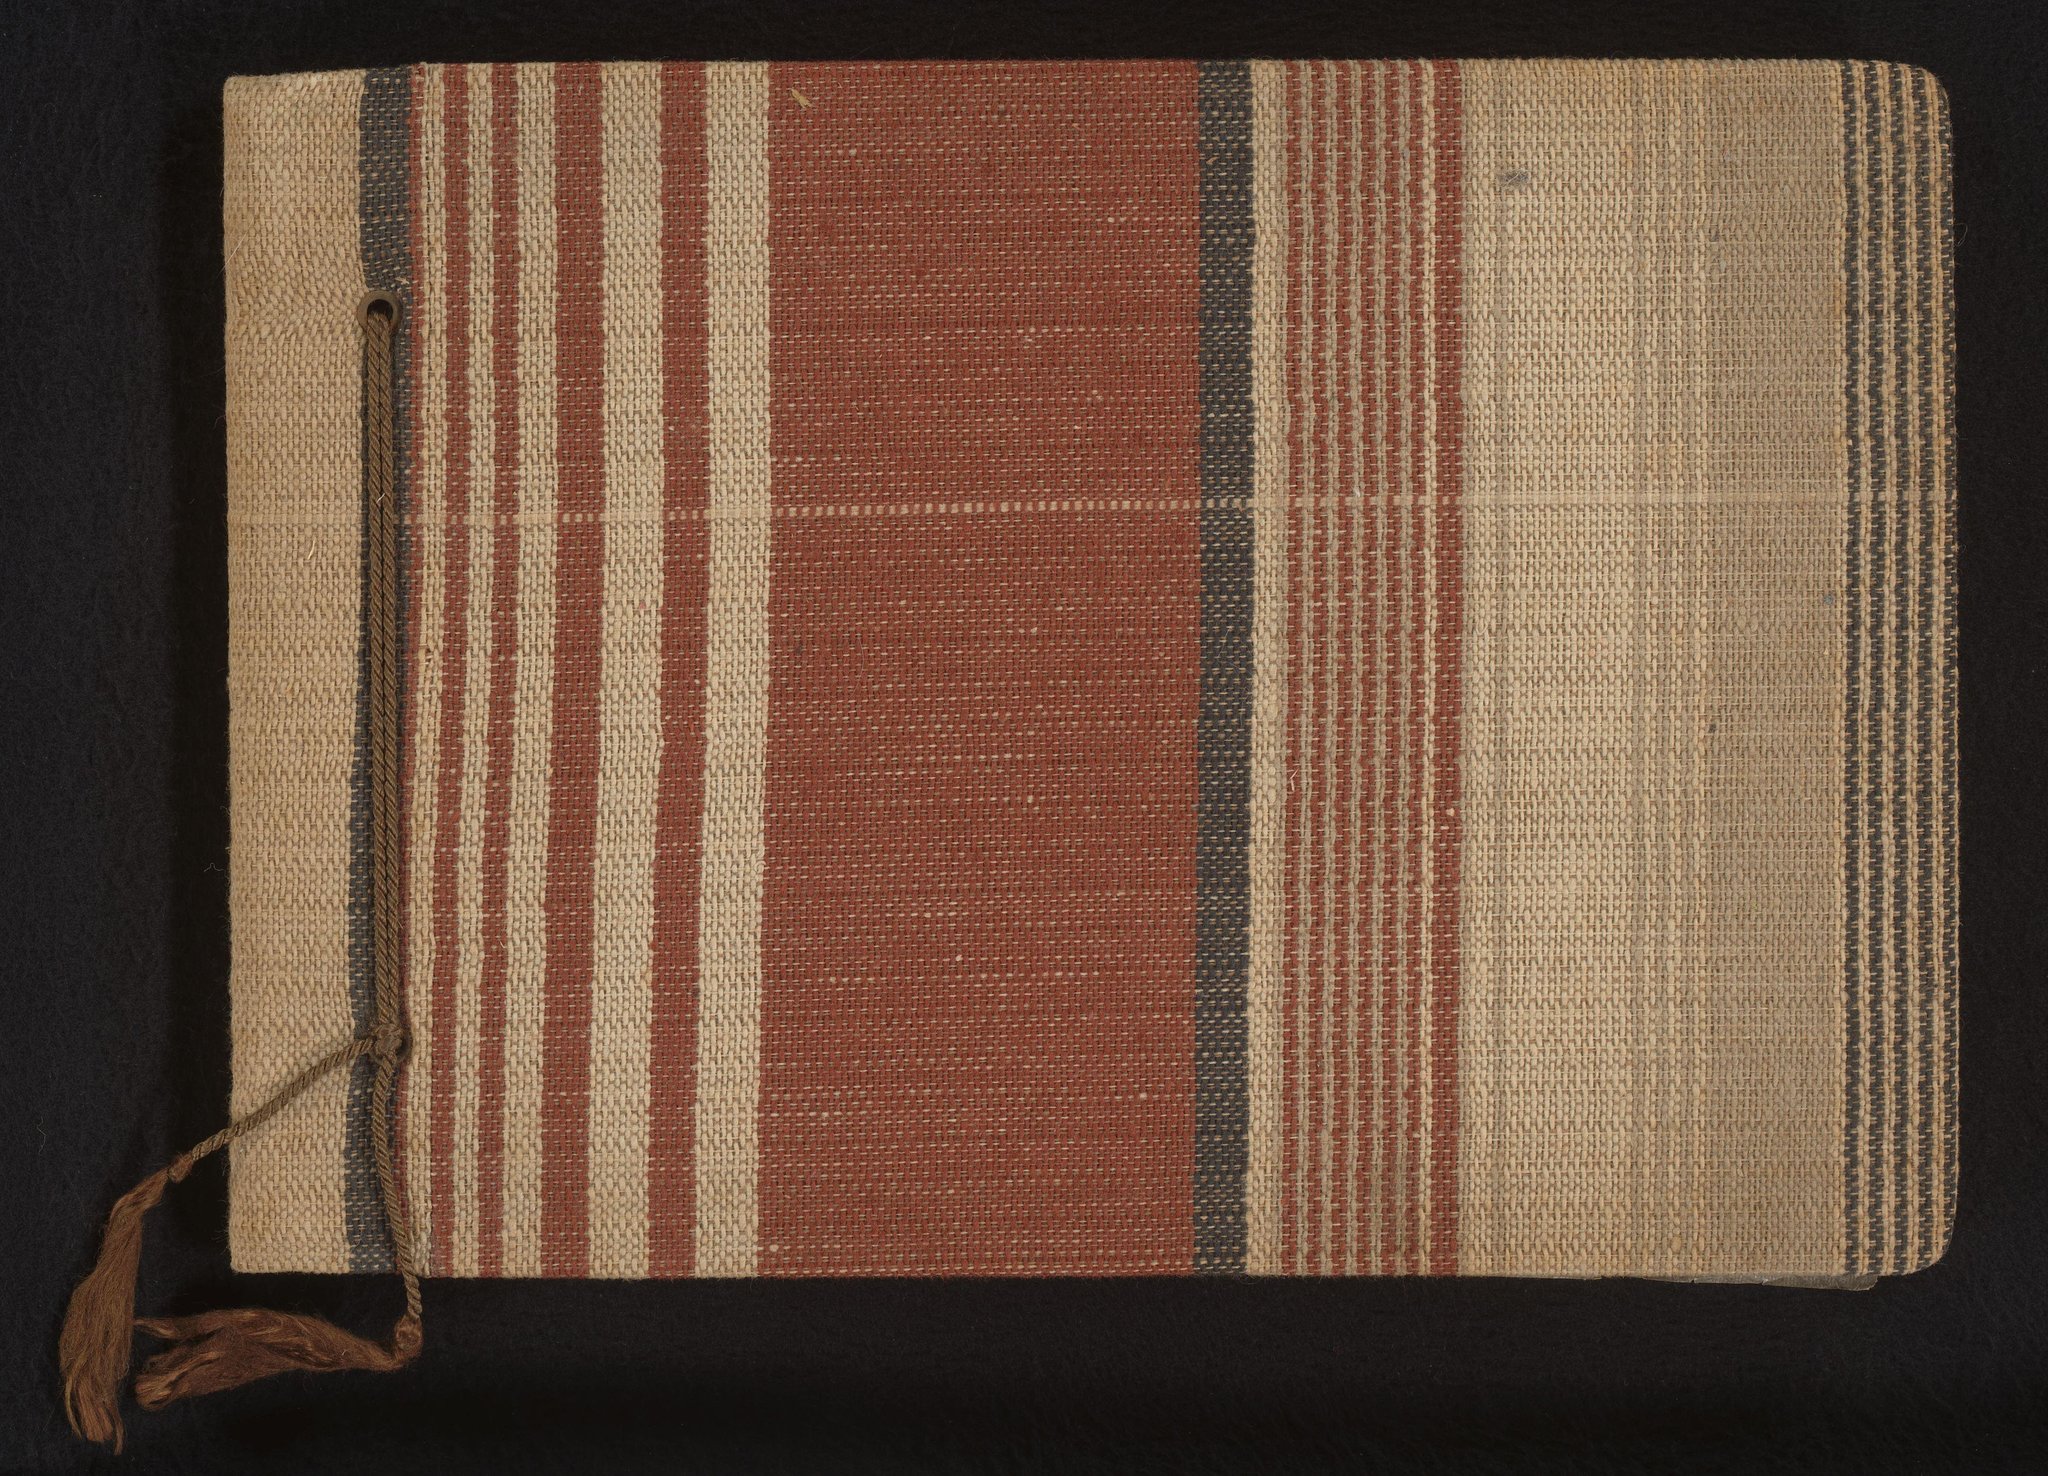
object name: photograph album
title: Reisalbum van een familievakantie in onder andere Zwitserland en Nederland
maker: Anonymous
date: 1938-1939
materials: paper, photographic support, textile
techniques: gelatin silver print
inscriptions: annotation: ‘25 Juli - 22 Aug 1938/ Hotel des Salines. Be[...] les Bains/ Zwitserland (Vaud)/ Directeur W. J. Oehler’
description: Fotoalbum met 48 pagina's waarvan er 18 foto's bevatten. In totaal bevat het album 32 foto's en twee silhouetportretten. Pagina's 1, 3, 16-24, 26, 27, 20-25 en 38-49 bevatten geen foto's maar in sommige gevallen is te zien dat die daar wel zaten door ingeplakte hoekjes of annotaties. Het album bevat foto's van reizen door onder andere Nederland en Zwitserland.